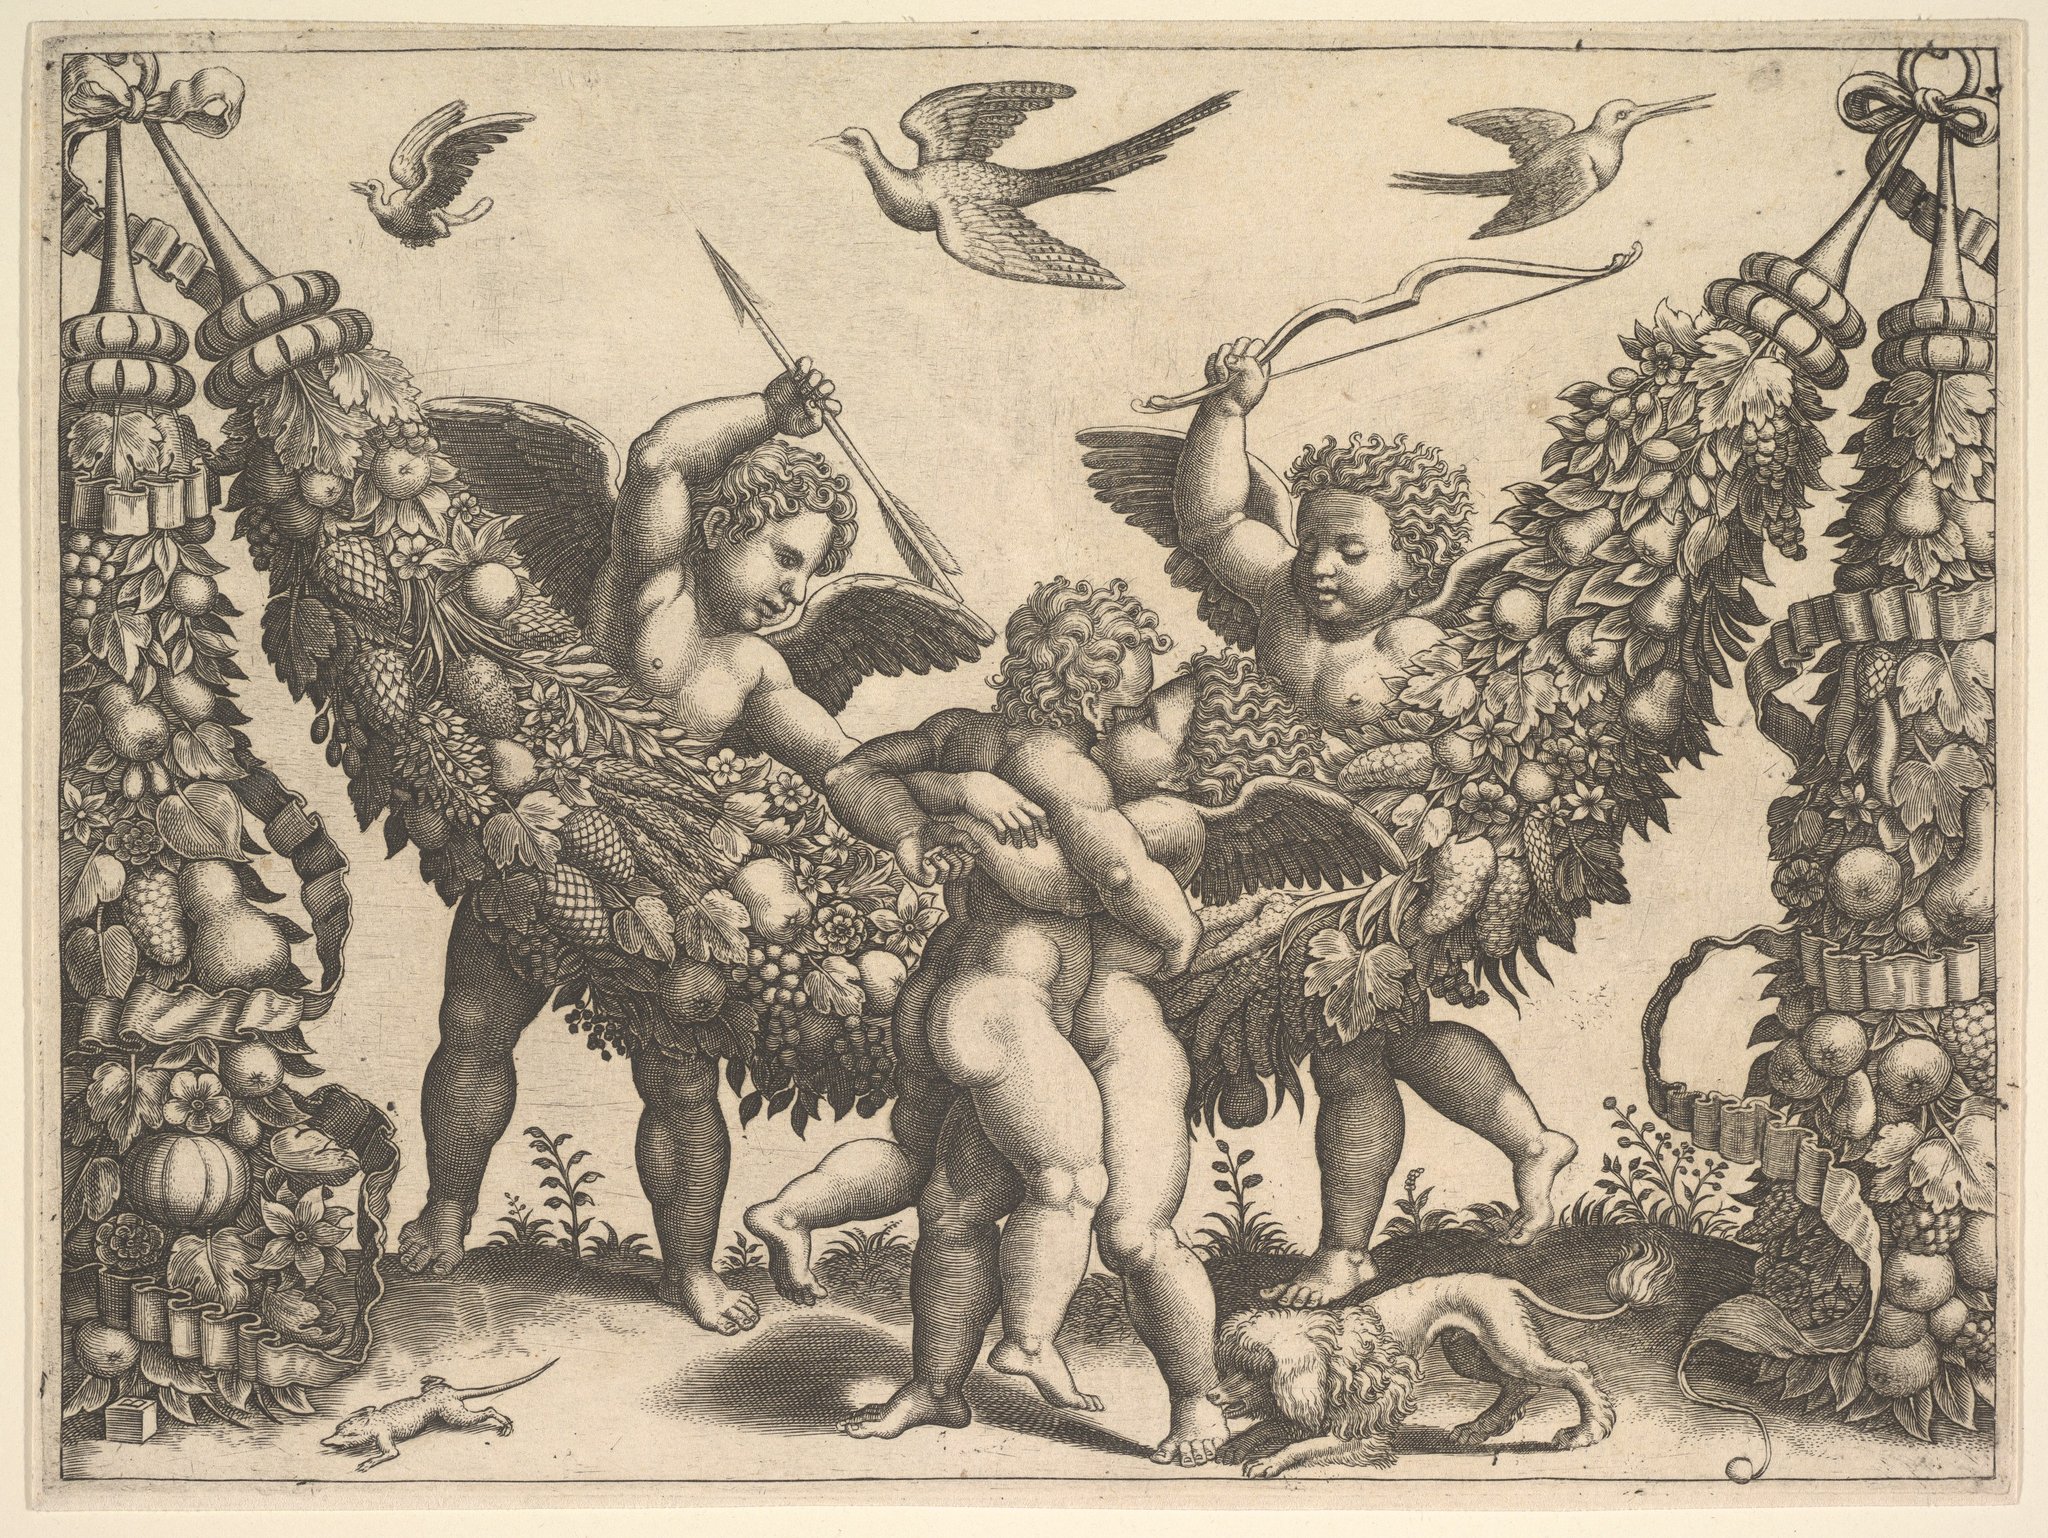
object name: print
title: Four putti, two embracing in front of a large garland, two behind, the one at left holding an arrow, the one at right a bow, from a series of tapestries made for Leo X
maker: master of the die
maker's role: artist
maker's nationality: italian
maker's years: 1525-1560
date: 1530-1540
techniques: engraving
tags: birds,bow and arrow,garlands,putti,dogs